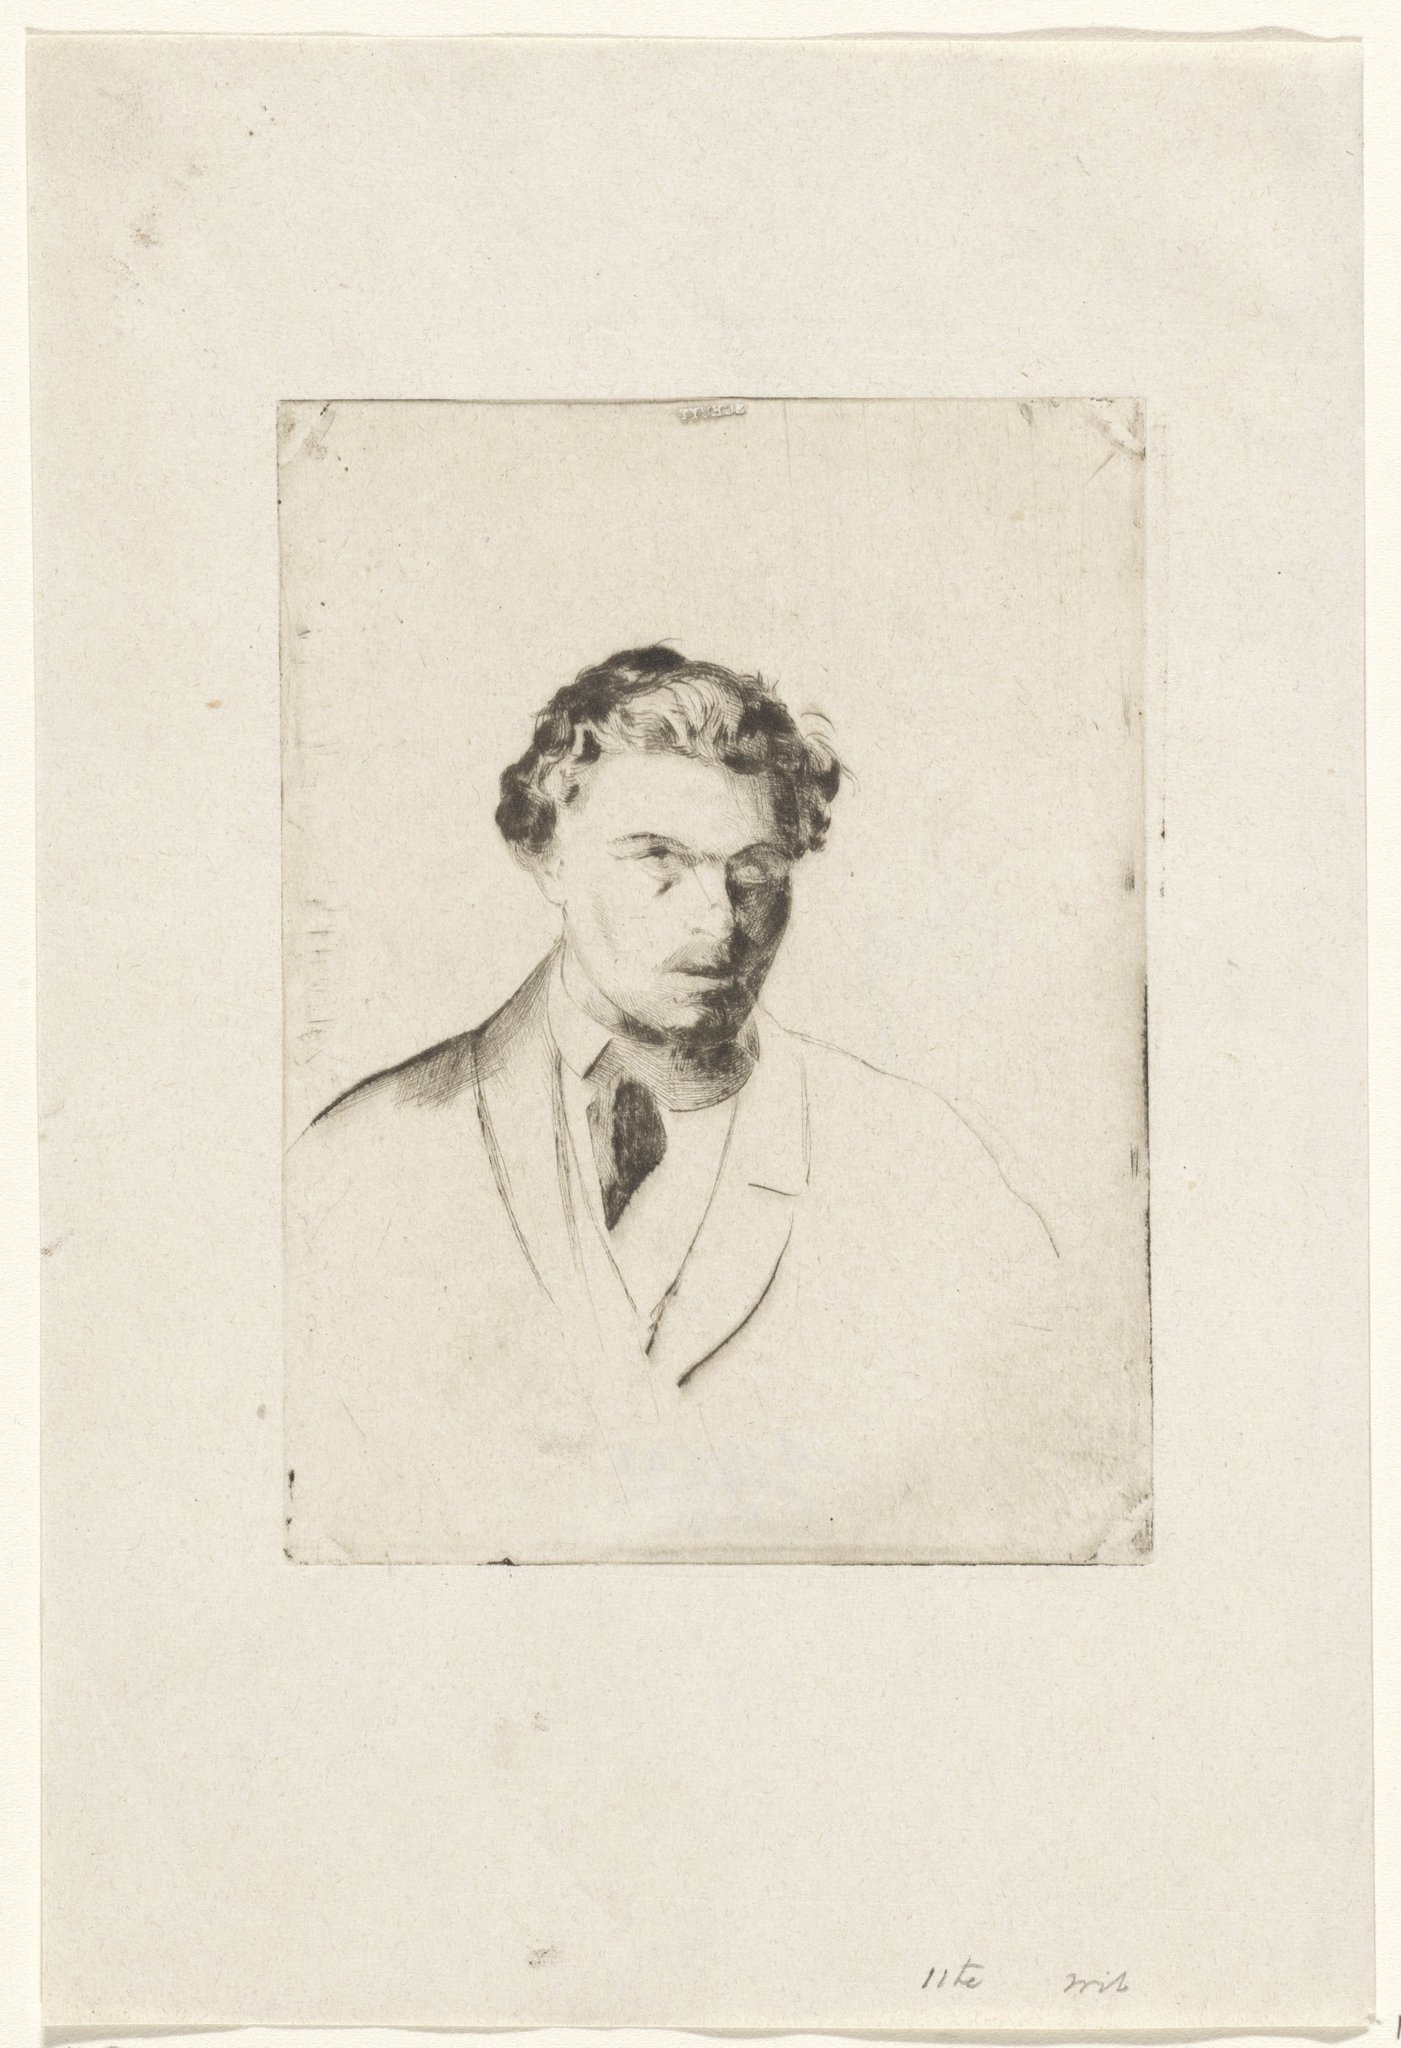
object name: print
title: Zelfportret van Frederik Hendrik Weissenbruch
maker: frederik hendrik weissenbruch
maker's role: draughtsman, print maker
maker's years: 1828-1887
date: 1843-1887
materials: paper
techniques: etching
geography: the hague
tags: the hague, print maker, draughtsman, frederik hendrik weissenbruch, portrait, self-portrait of artist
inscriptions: collector's mark: Lugt 2228